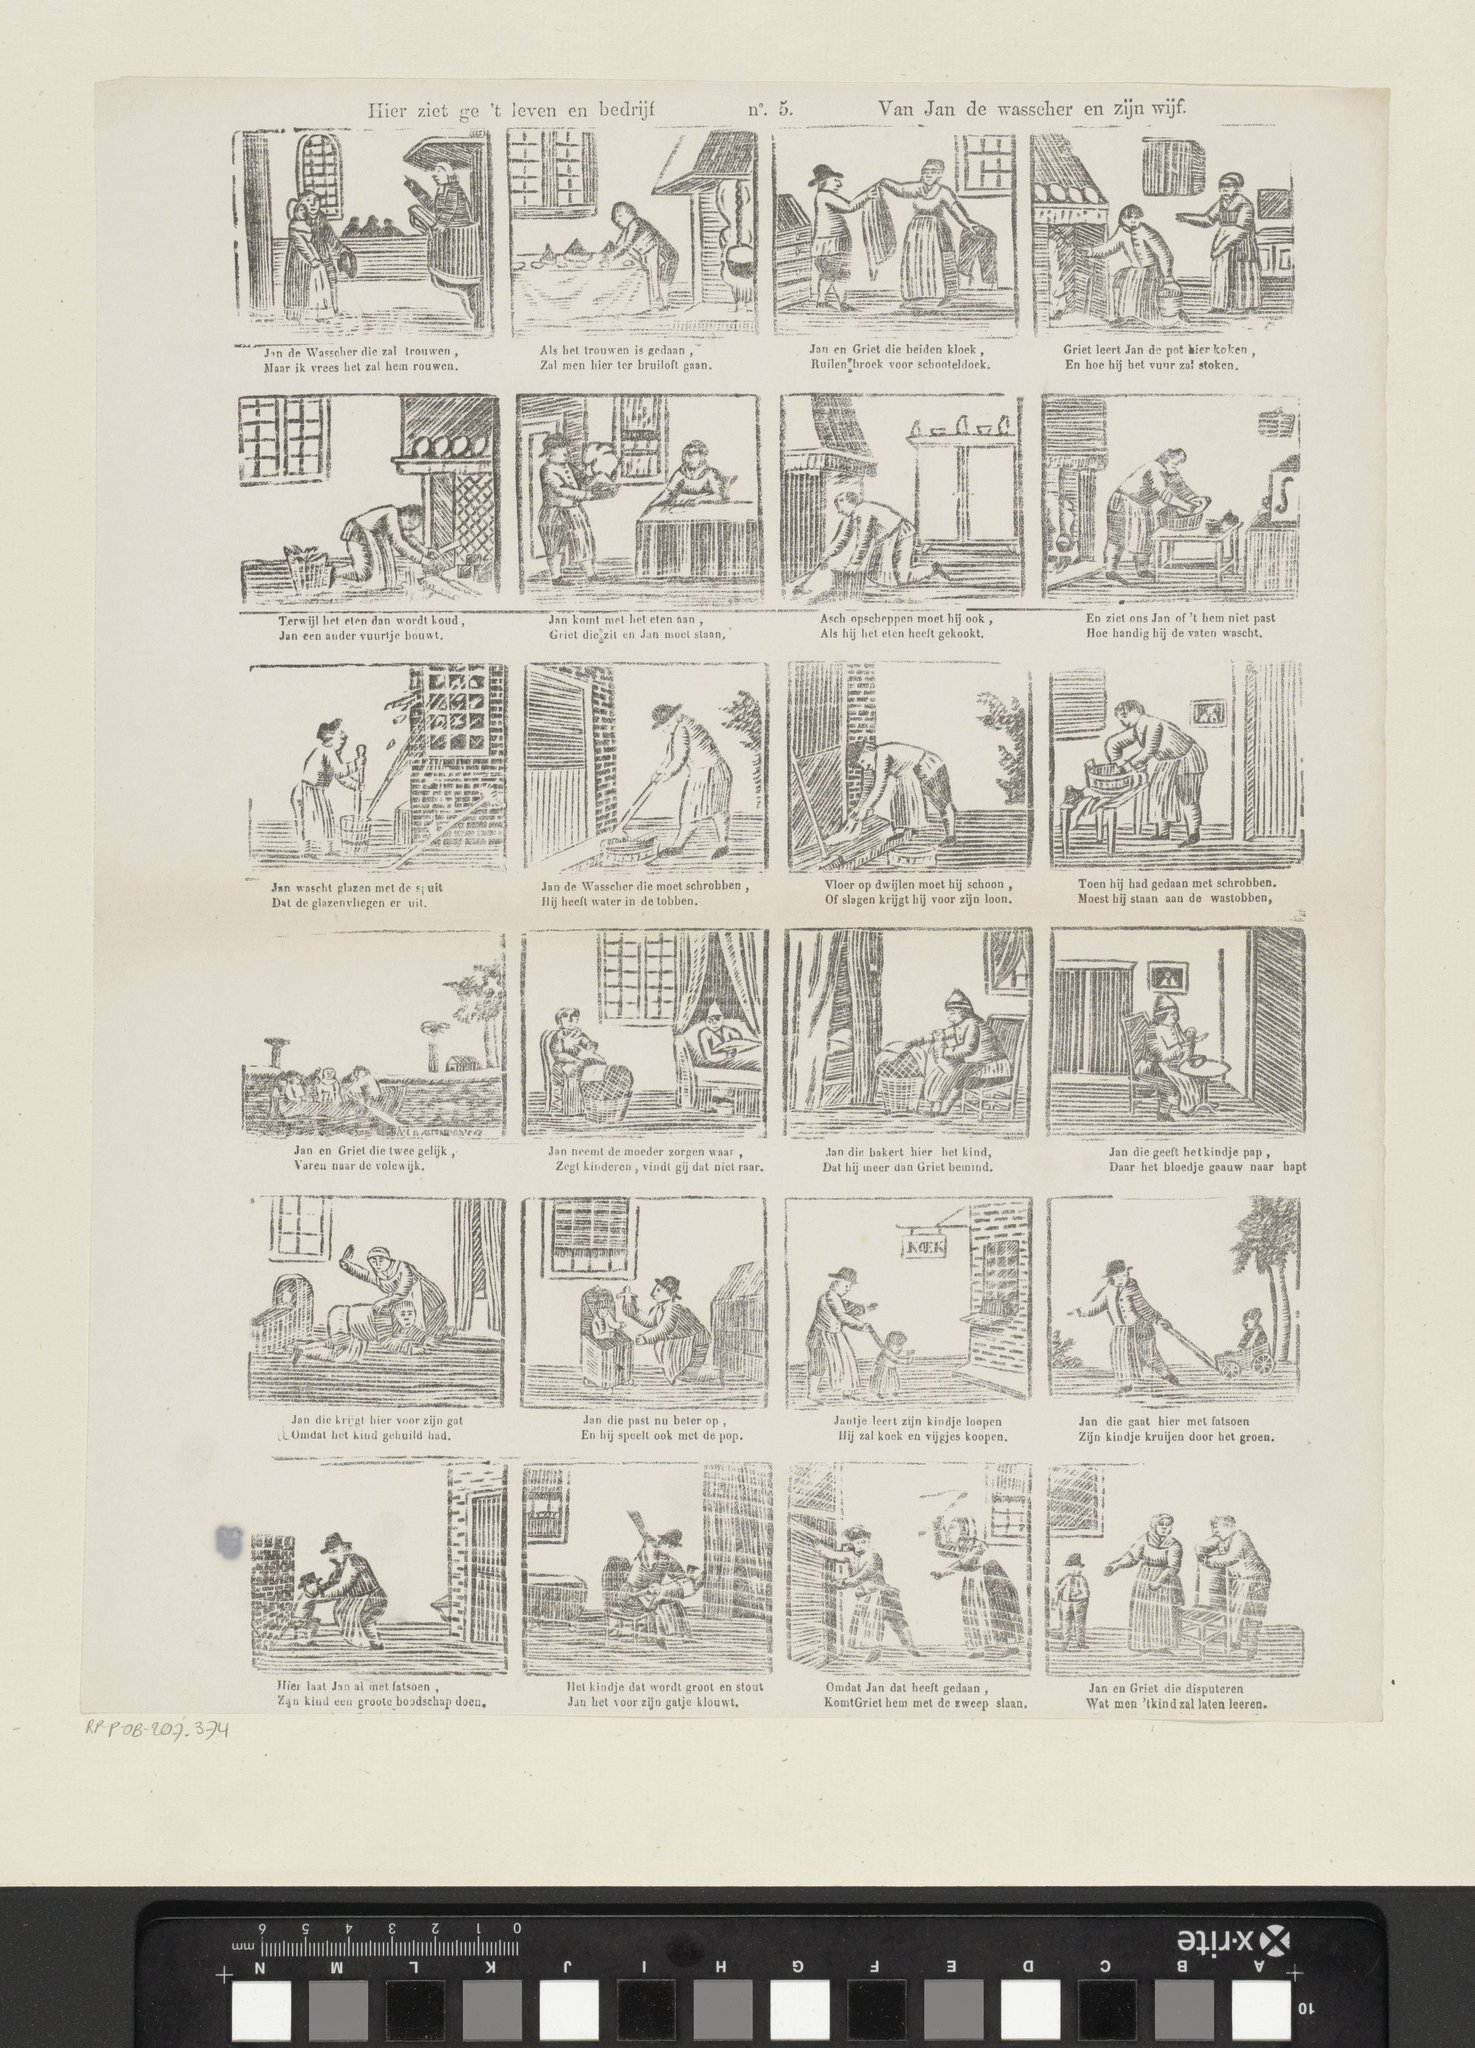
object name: print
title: Hier ziet ge 't leven en bedrijf / Van Jan de Wasscher en zijn wijf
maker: alexander cranendoncq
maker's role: draughtsman, print maker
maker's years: 1799-1869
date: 1848-1881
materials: paper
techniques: letterpress printing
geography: netherlands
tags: hen-pecked husband, 'betty', 'molly' (man who engages in women's work)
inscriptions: collector's mark: Lugt 2760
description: Blad met 24 voorstellingen uit het leven van Jan de Wasser, een man die van zijn vrouw Griet, die de broek aan heeft, al het huishoudelijk werk moet doen. Onder elke afbeelding een tweeregelig vers. Genummerd midden boven: no. 5.